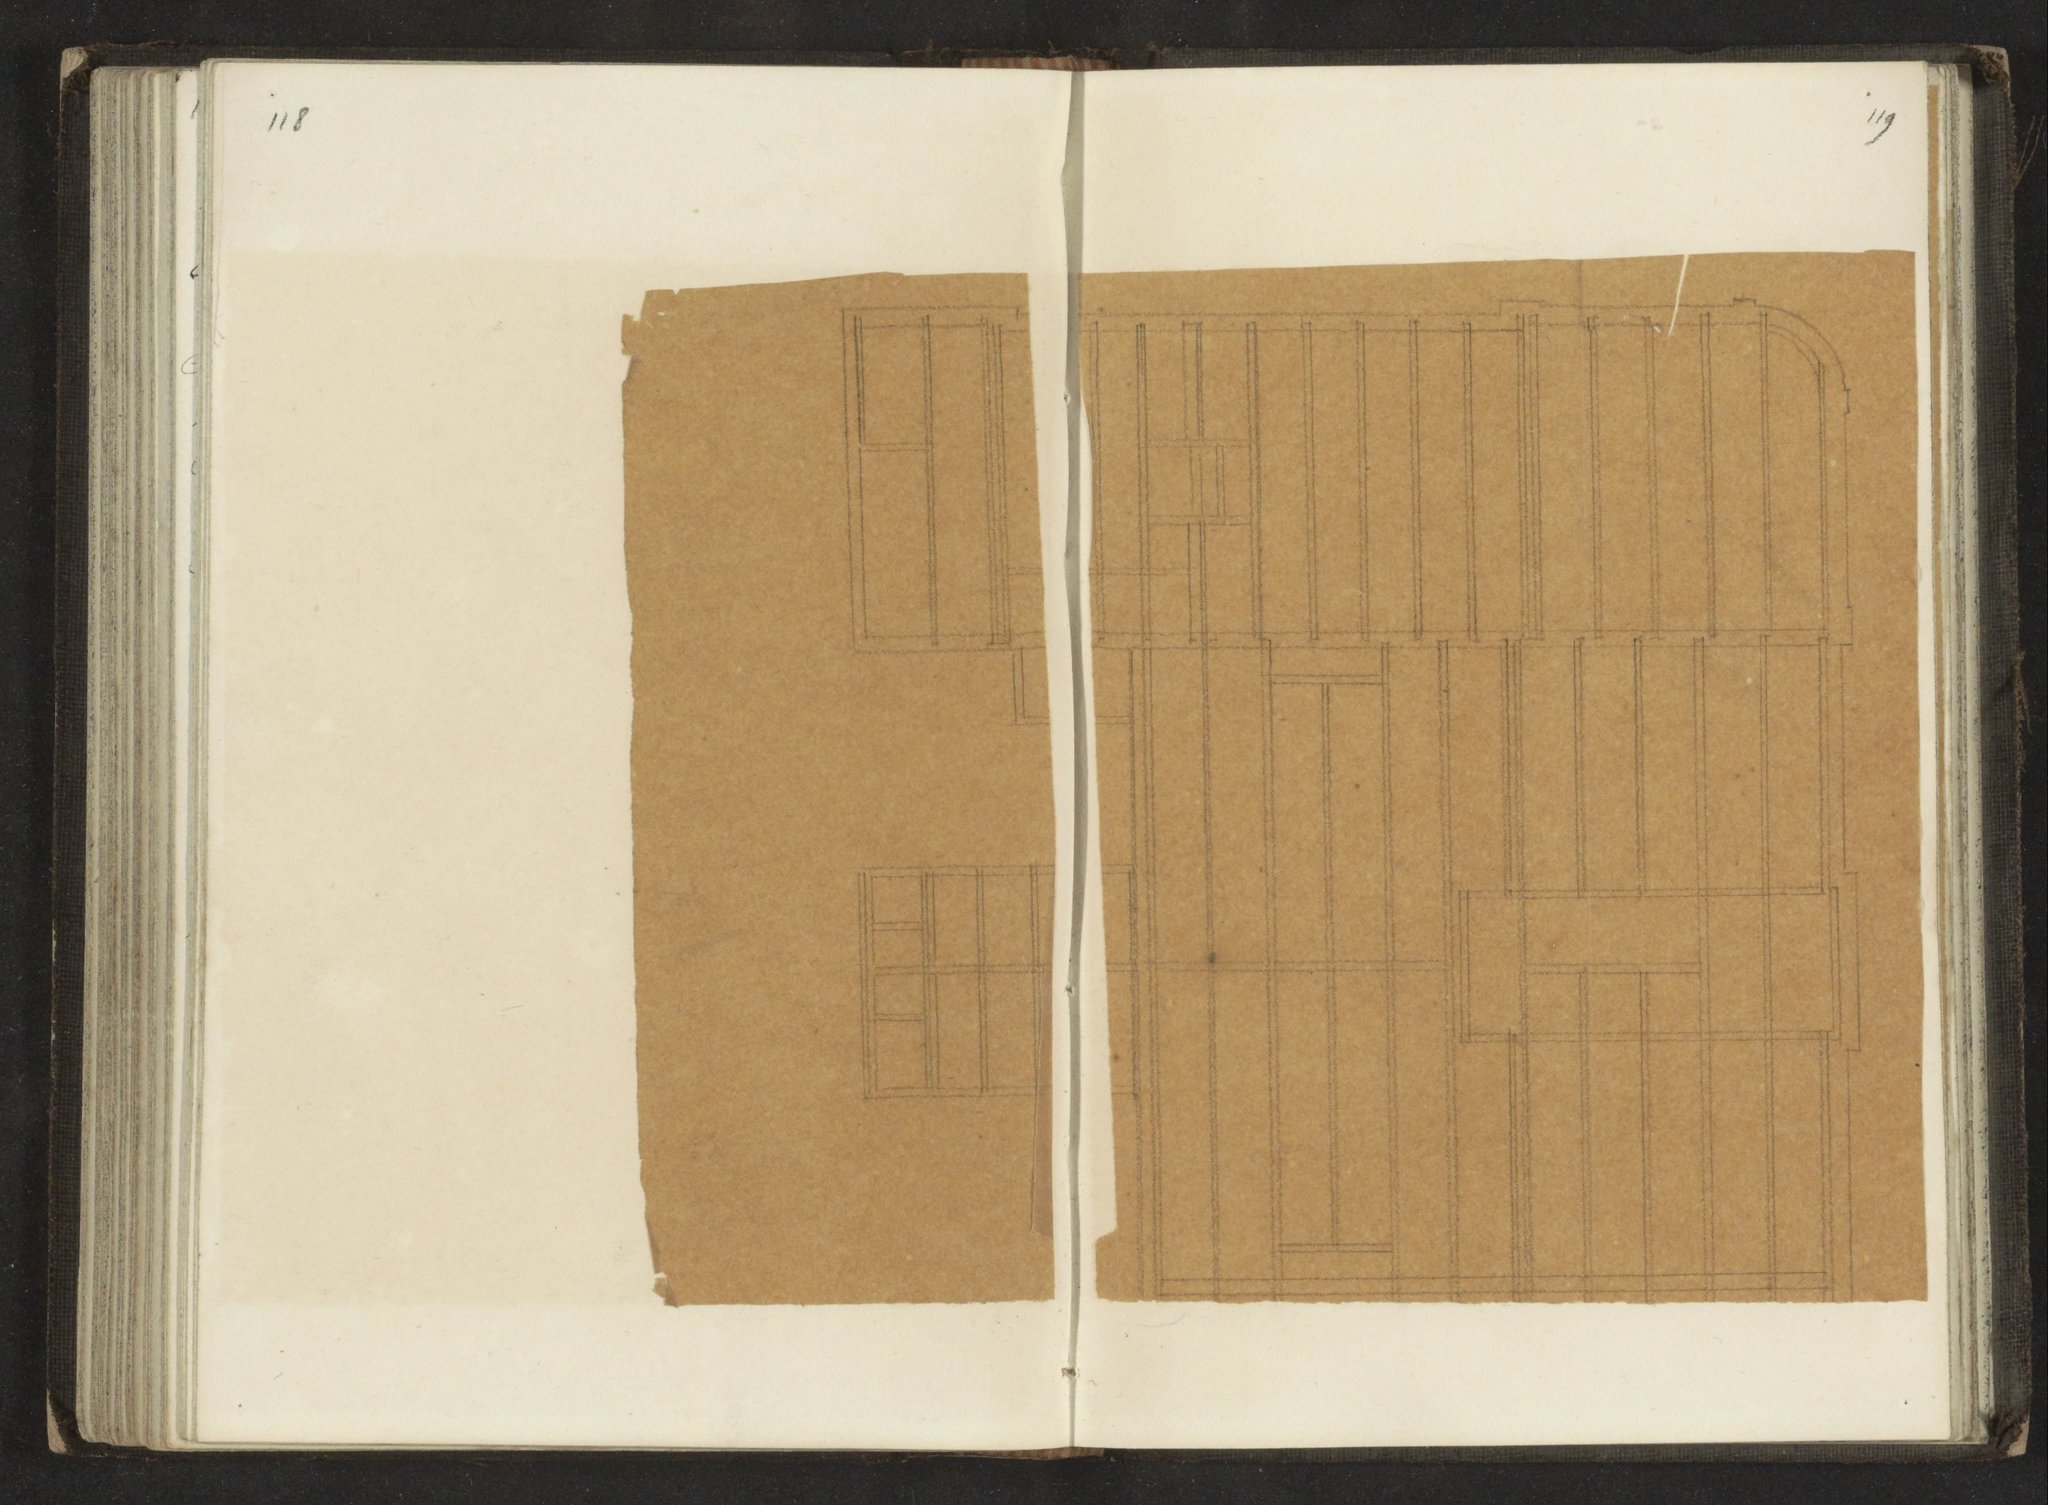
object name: sketchbook leaf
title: Plattegrond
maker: willem springer jr.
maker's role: draughtsman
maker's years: 1815-1907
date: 1864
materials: paper, pencil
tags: plan ~ architecture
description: Pagina 118 en 119 uit een schetsboek met 164 pagina's.